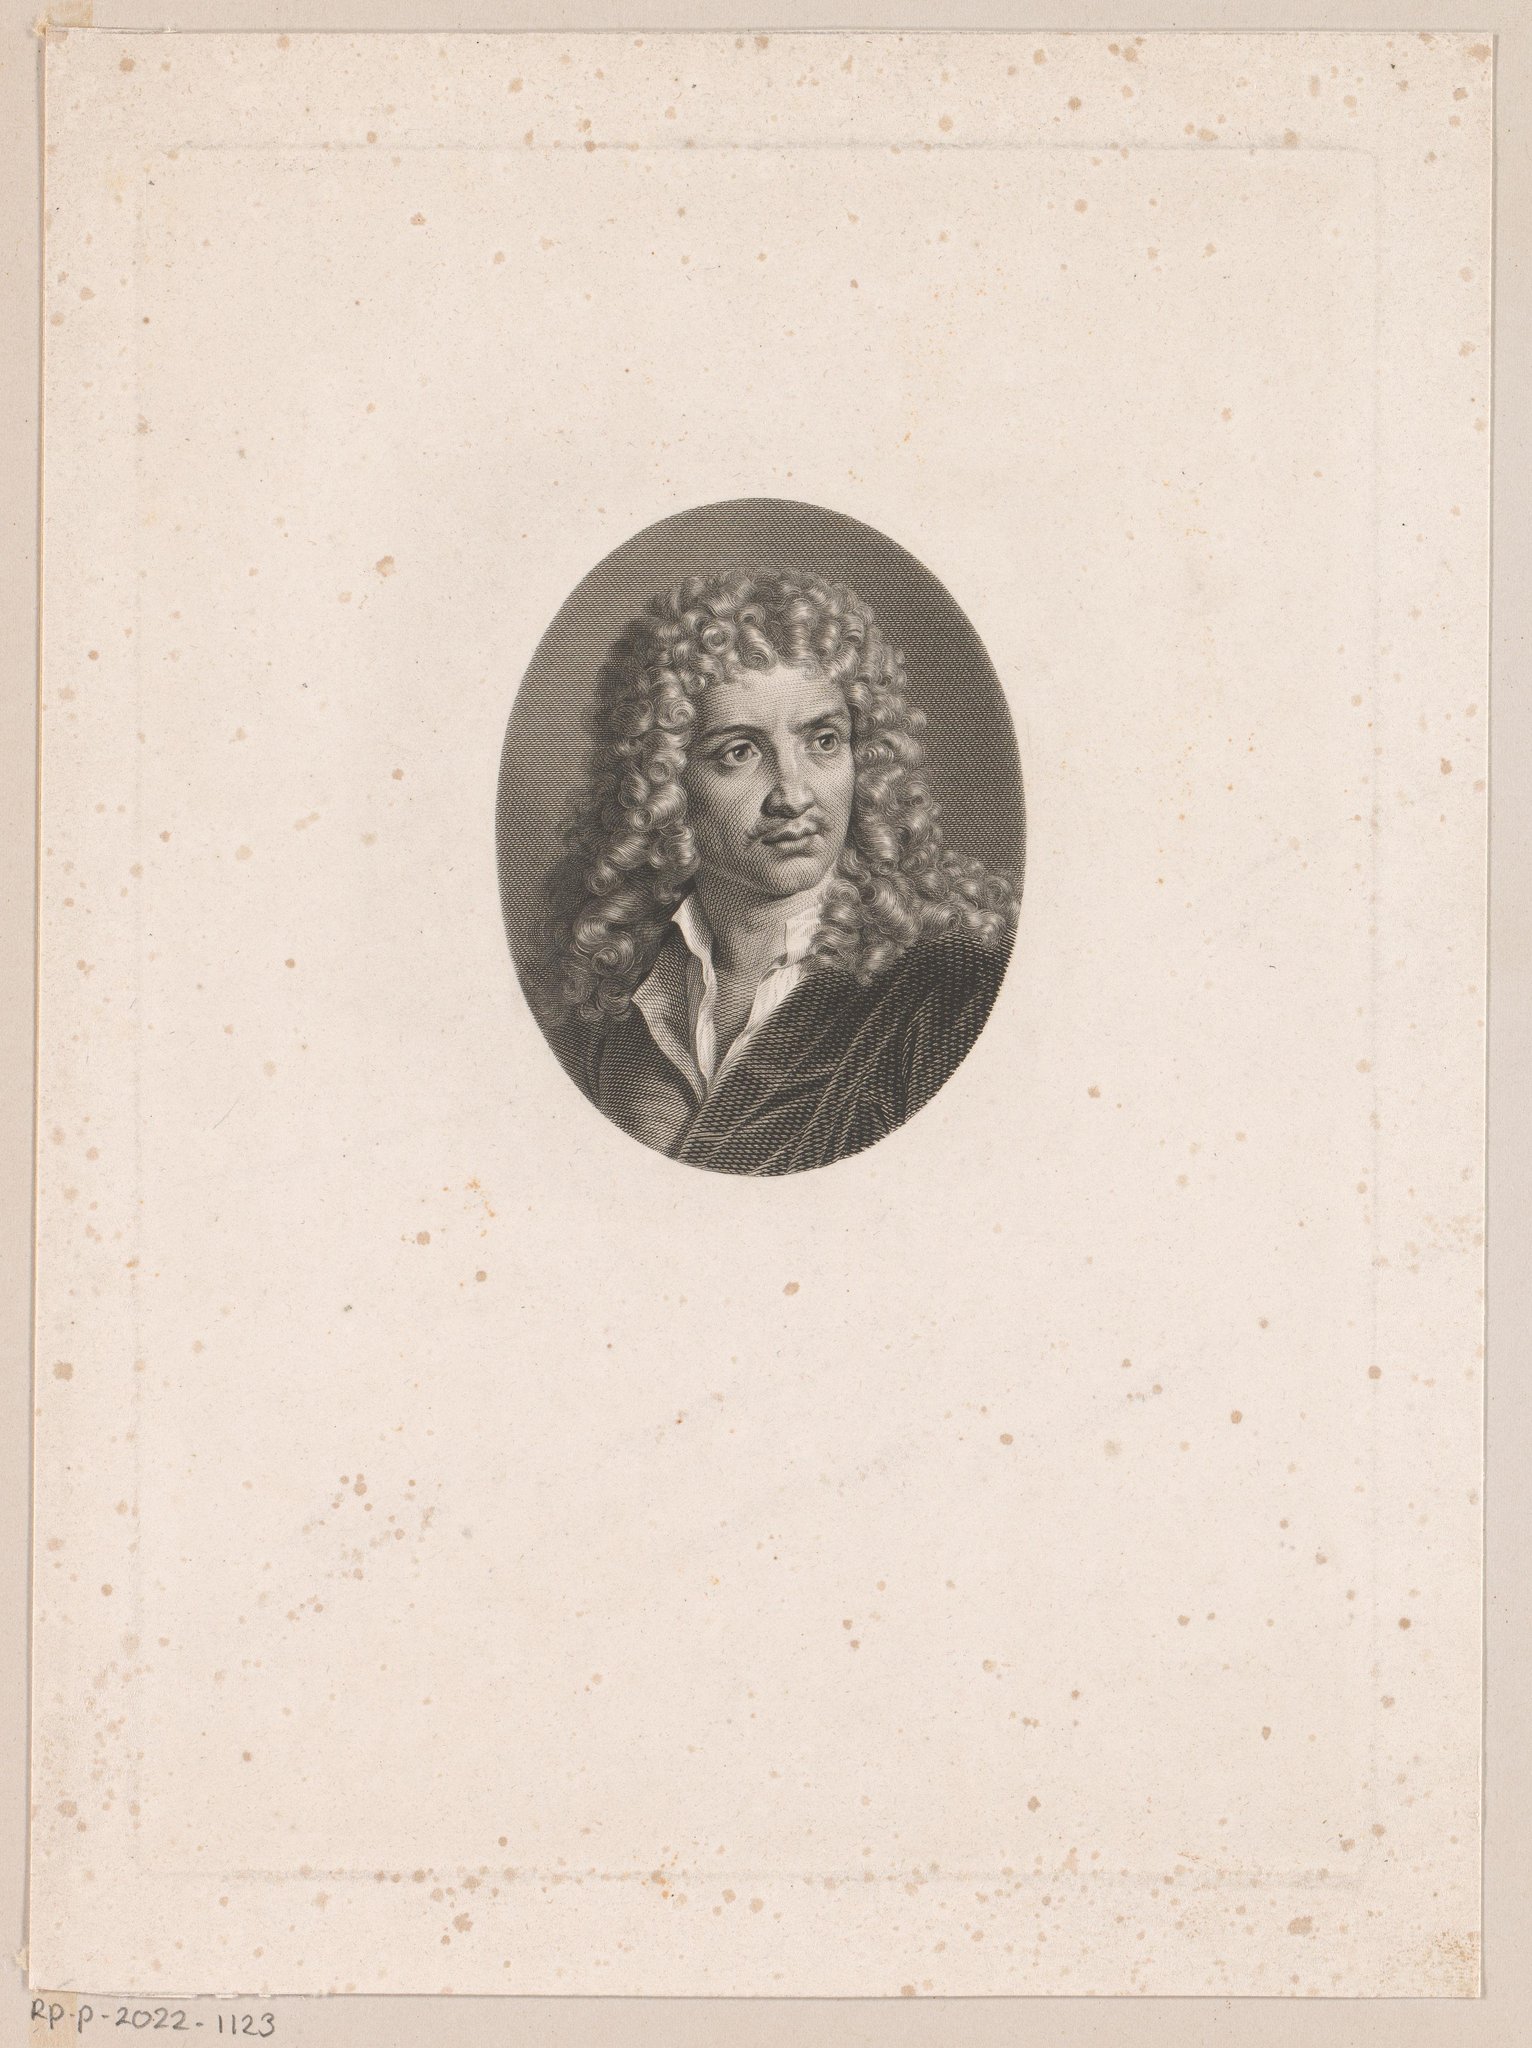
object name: print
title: Portret van Jean Baptiste Poquelin Molière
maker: Anonymous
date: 1650-1750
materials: paper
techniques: engraving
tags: paris, jean baptiste poquelin molière, historical persons, writer, poet, author